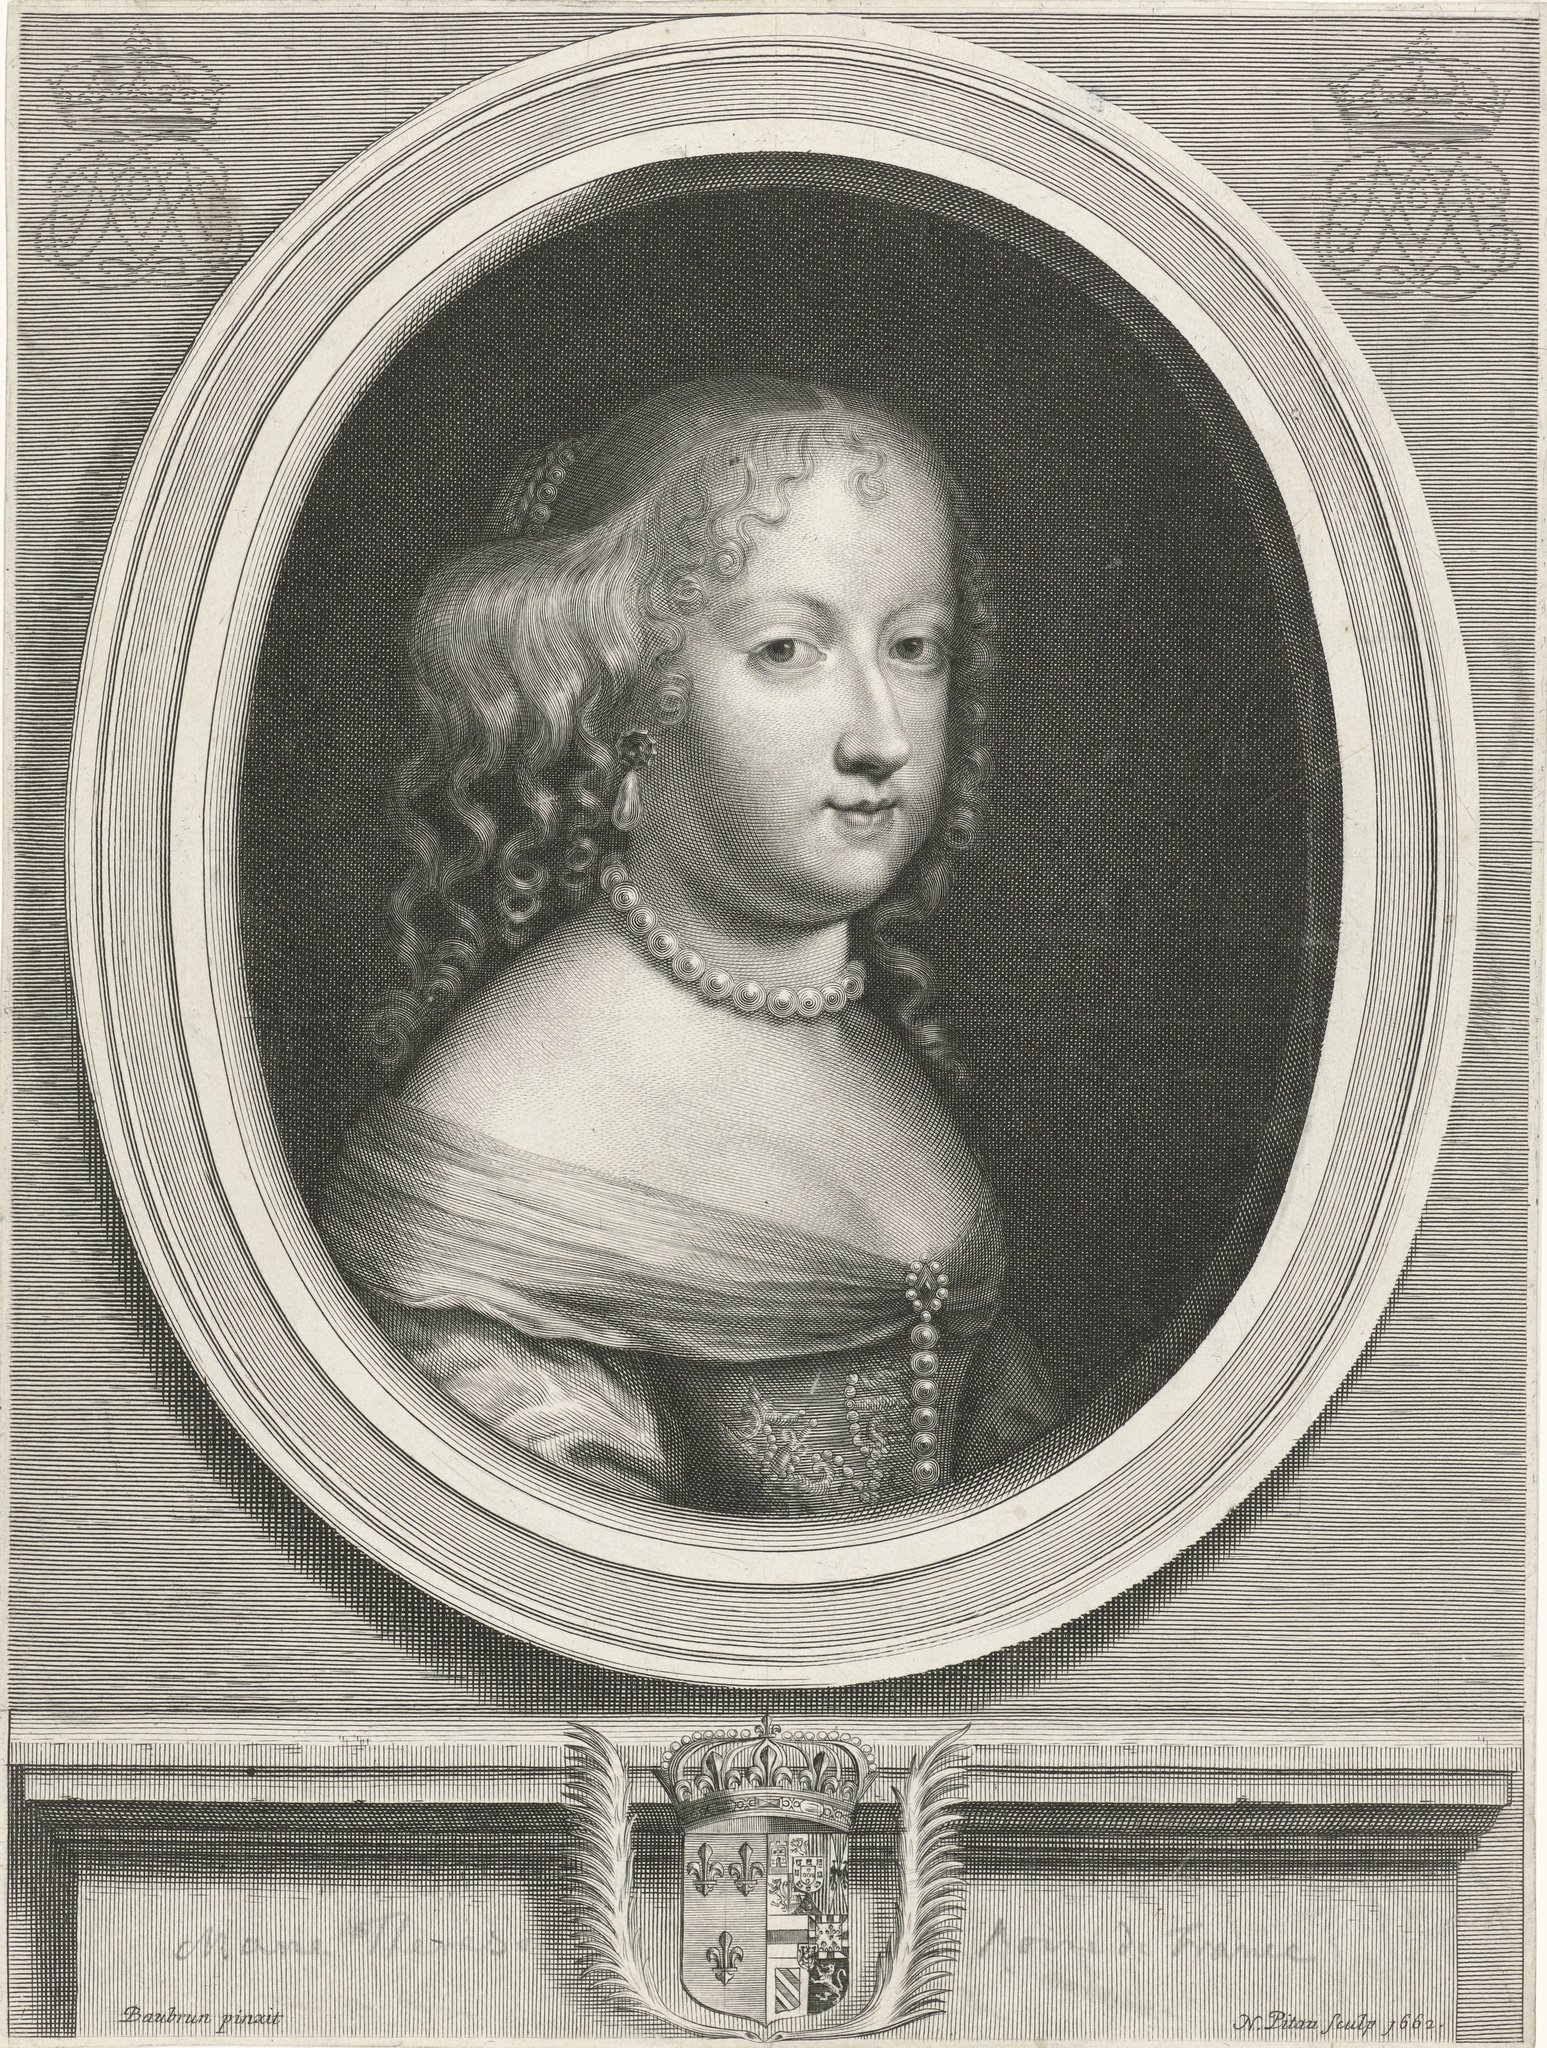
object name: print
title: Portret van Maria Theresia van Oostenrijk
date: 1662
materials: paper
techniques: engraving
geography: paris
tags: maria theresia (koningin van frankrijk), coat of arms (symbol of sovereignty)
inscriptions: number: ‘194’, collector's mark: Lugt 2228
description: Portret van Maria Theresia, koningin van Frankrijk. In de bovenhoeken een monogram met haar initialen. Op de piëdestal haar wapenschild.